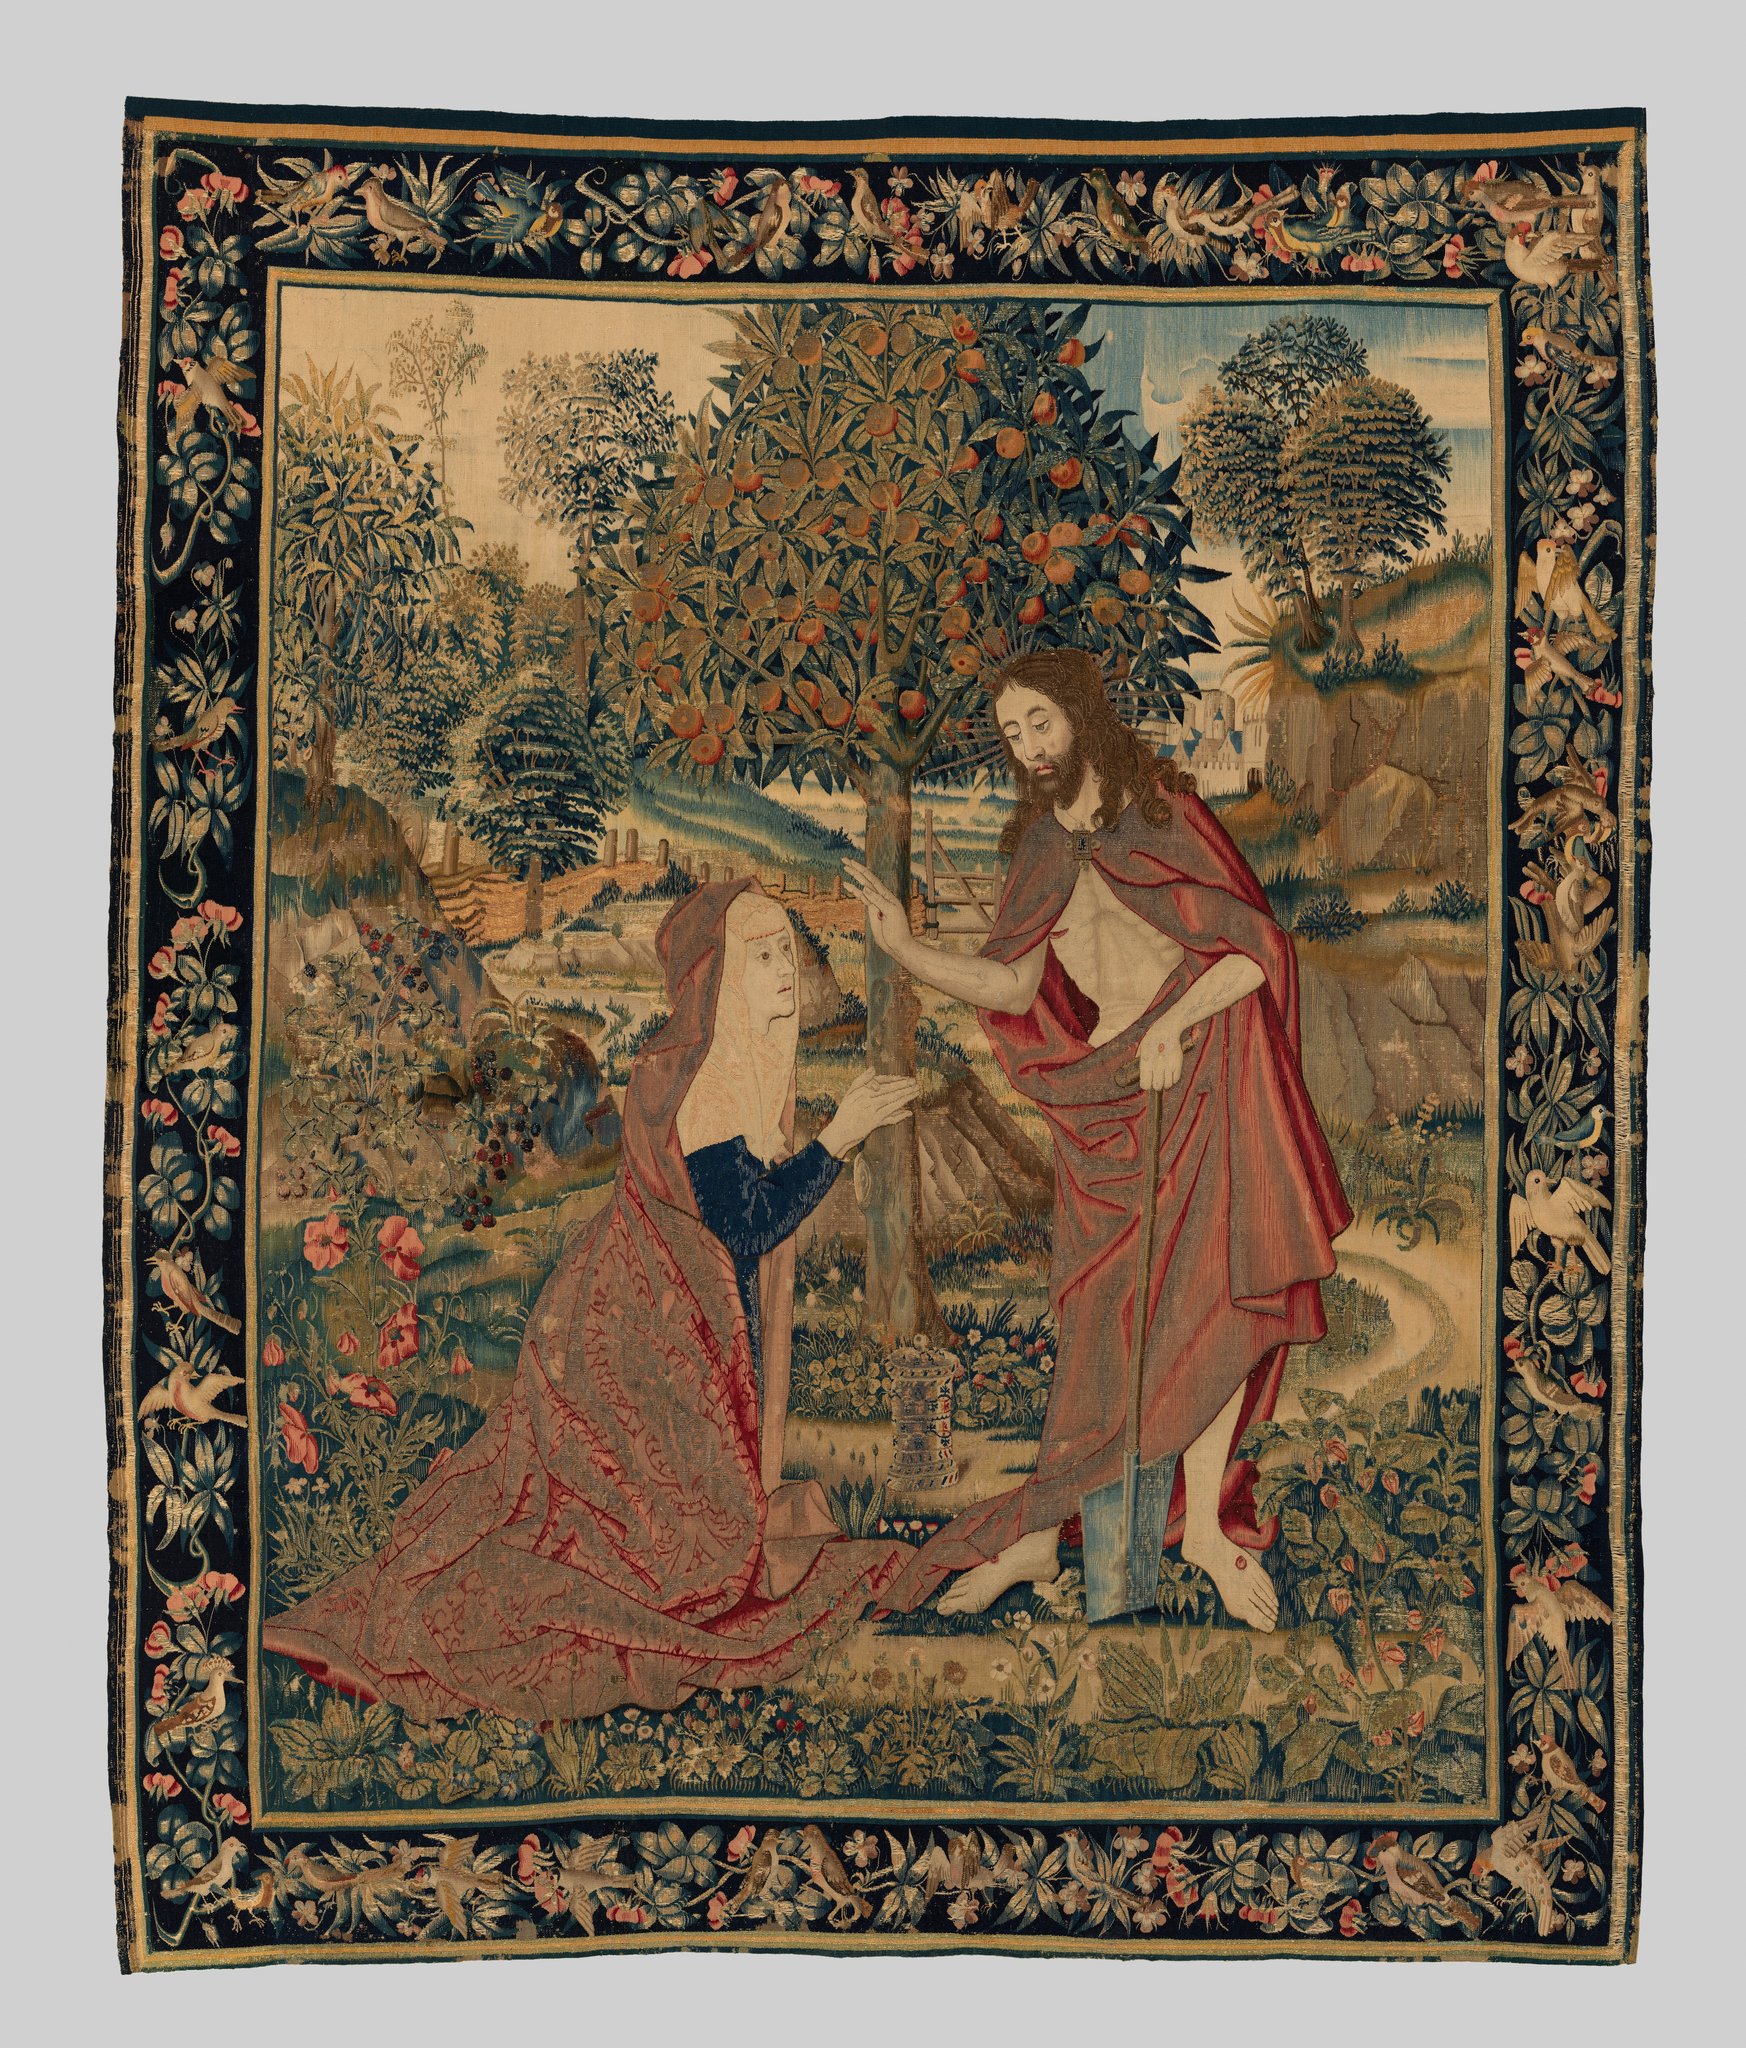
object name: tapestry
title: The Resurrected Christ Appearing to Mary Magdelene in the Garden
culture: south netherlandish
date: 1500-1520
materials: gilt, silk, wool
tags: birds,gardens,landscapes,christ,mary magdalene